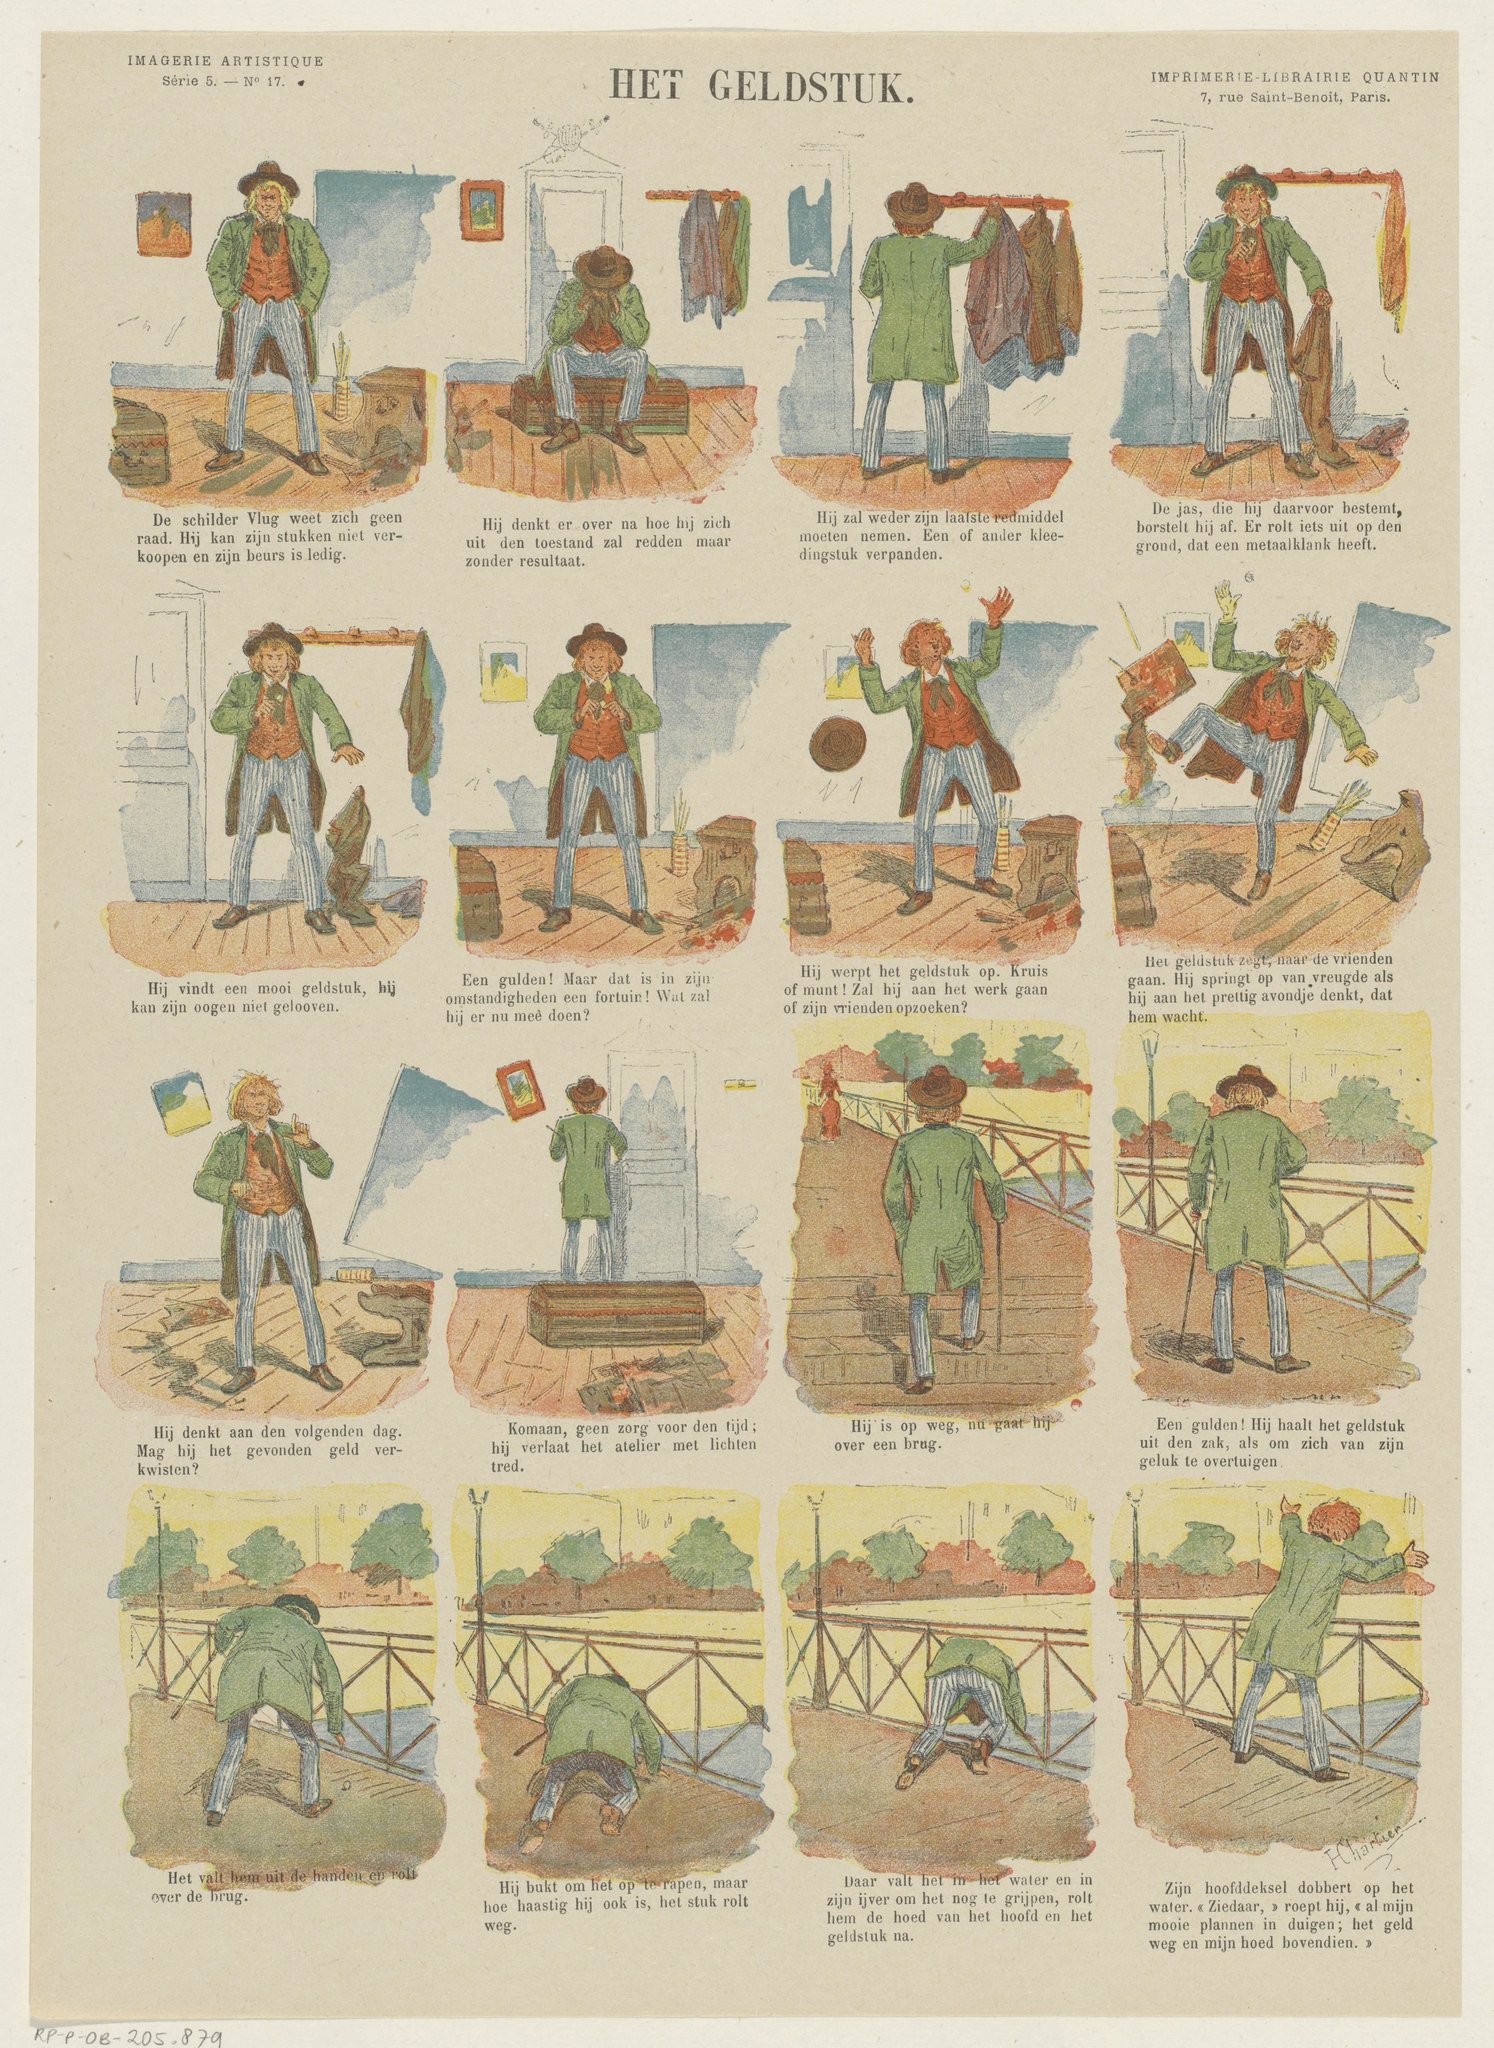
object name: popular print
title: Imagerie Artistique / Série 5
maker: albert quantin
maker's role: printer, publisher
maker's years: 1850-1933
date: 1876-1890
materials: paper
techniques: lithograph, letterpress printing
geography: paris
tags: workshop, studio ~ painter, tales and fairy tales, painter in non-work situation, money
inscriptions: collector's mark: Lugt 2760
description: Blad met 16 voorstellingen uit het verhaal van de schilder genaamd Vlug. Hij vindt een geldstuk en laat het perongeluk van een brug vallen. Onder elke voorstelling een onderschrift. Genummerd linksboven: Série 5. - No. 17.